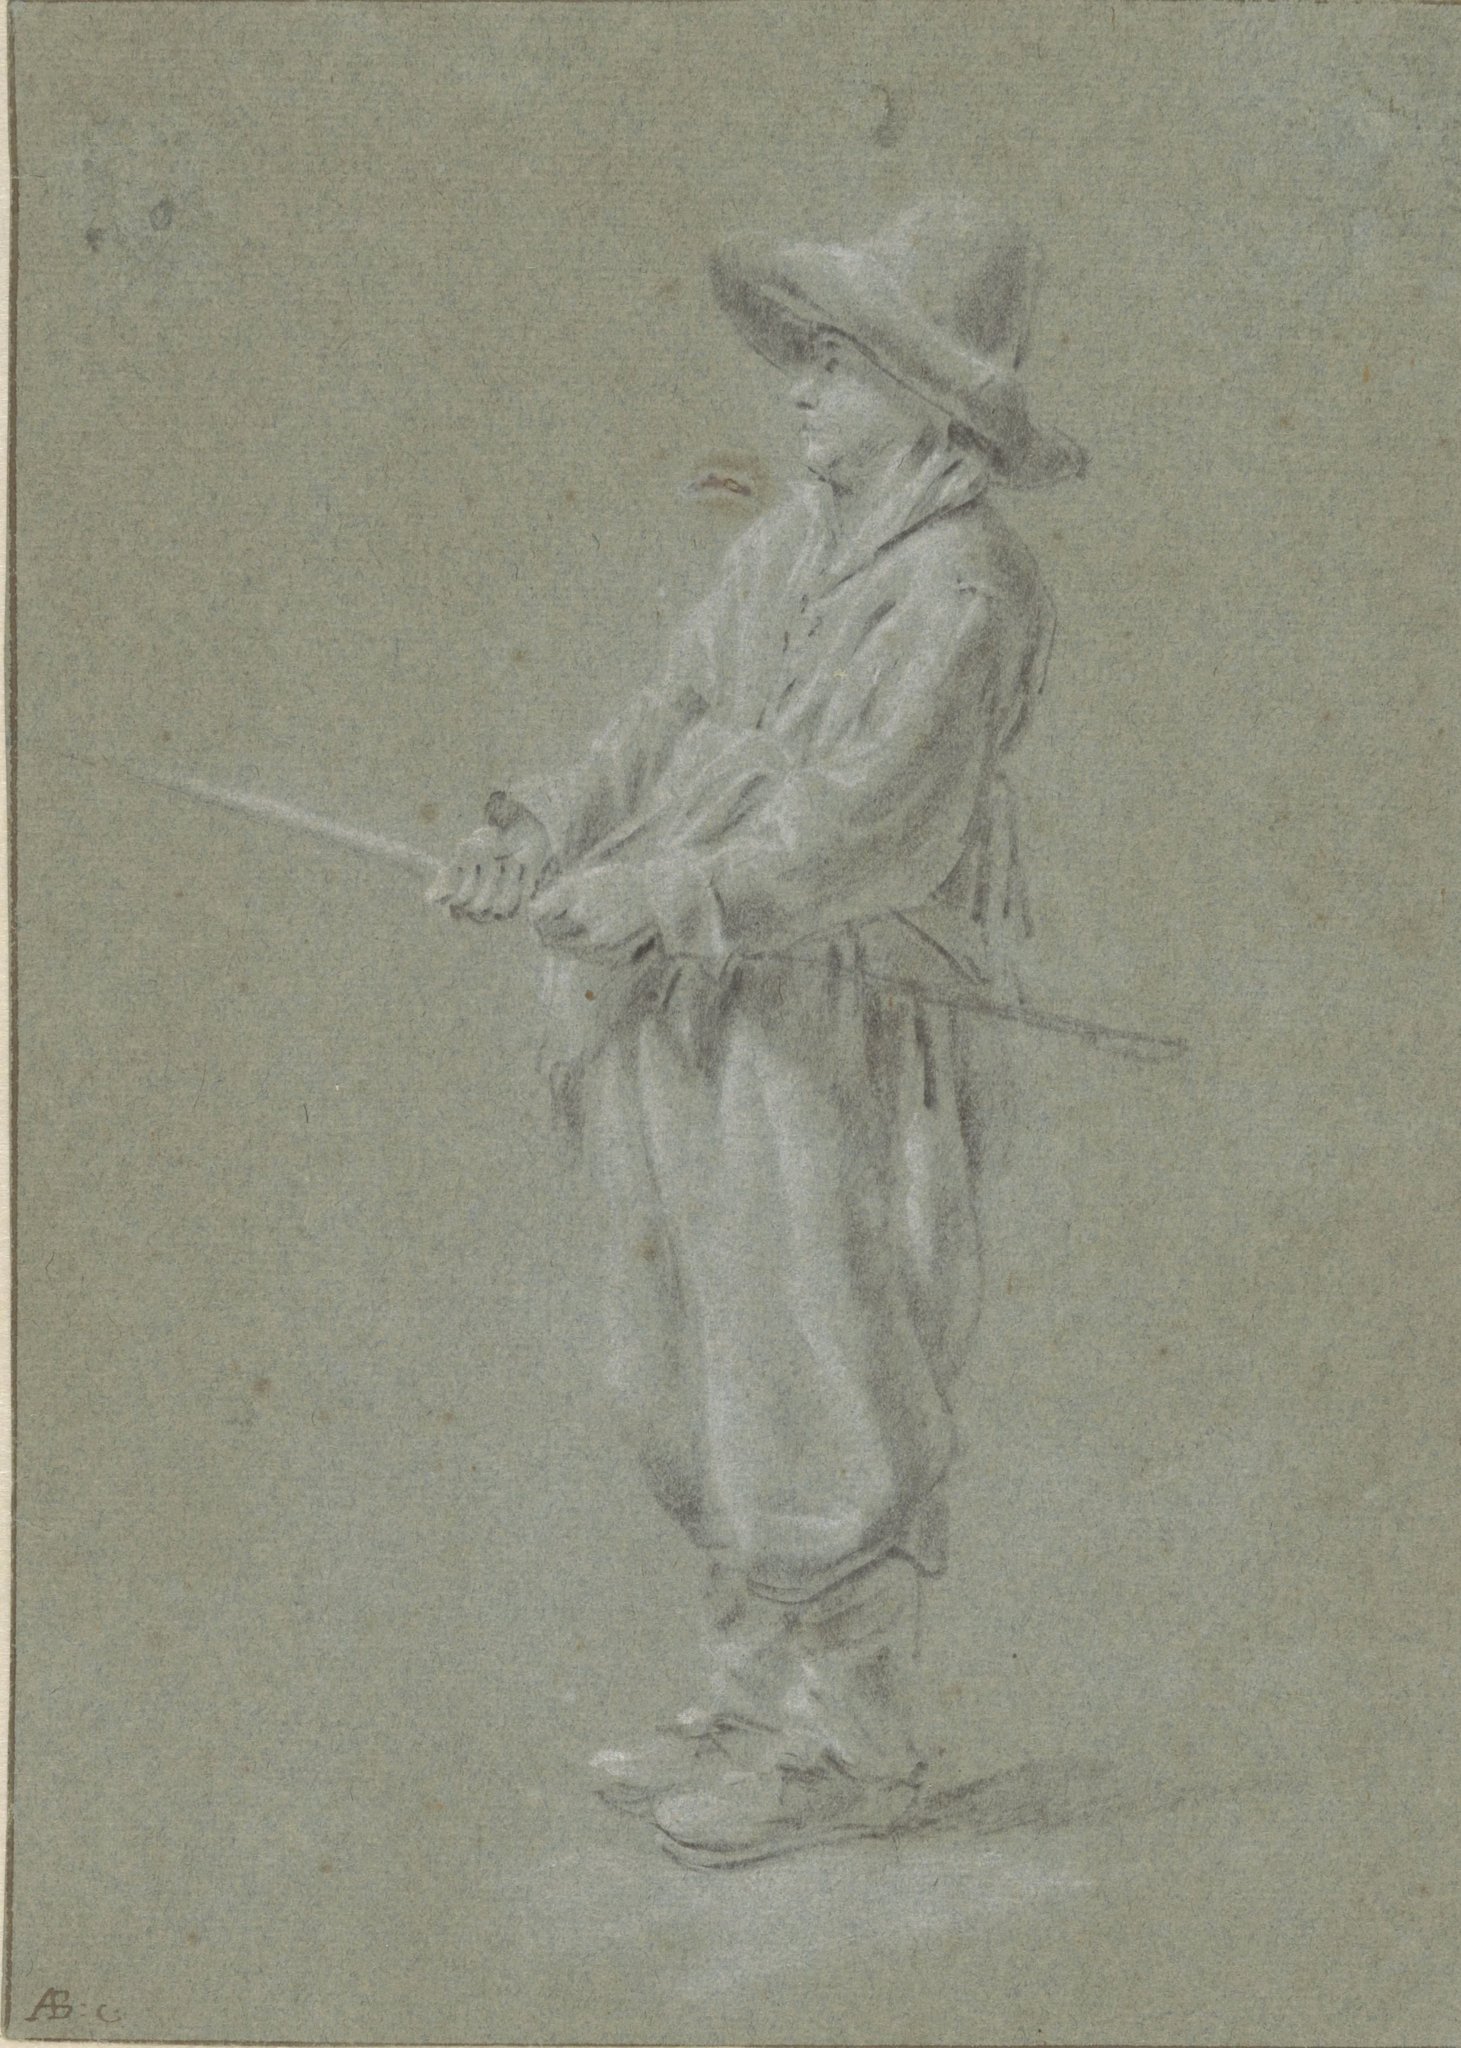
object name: drawing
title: Staande jongen met een hengel(?) in de handen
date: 1600-1699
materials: chalk, paper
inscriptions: monogram: ‘AB’